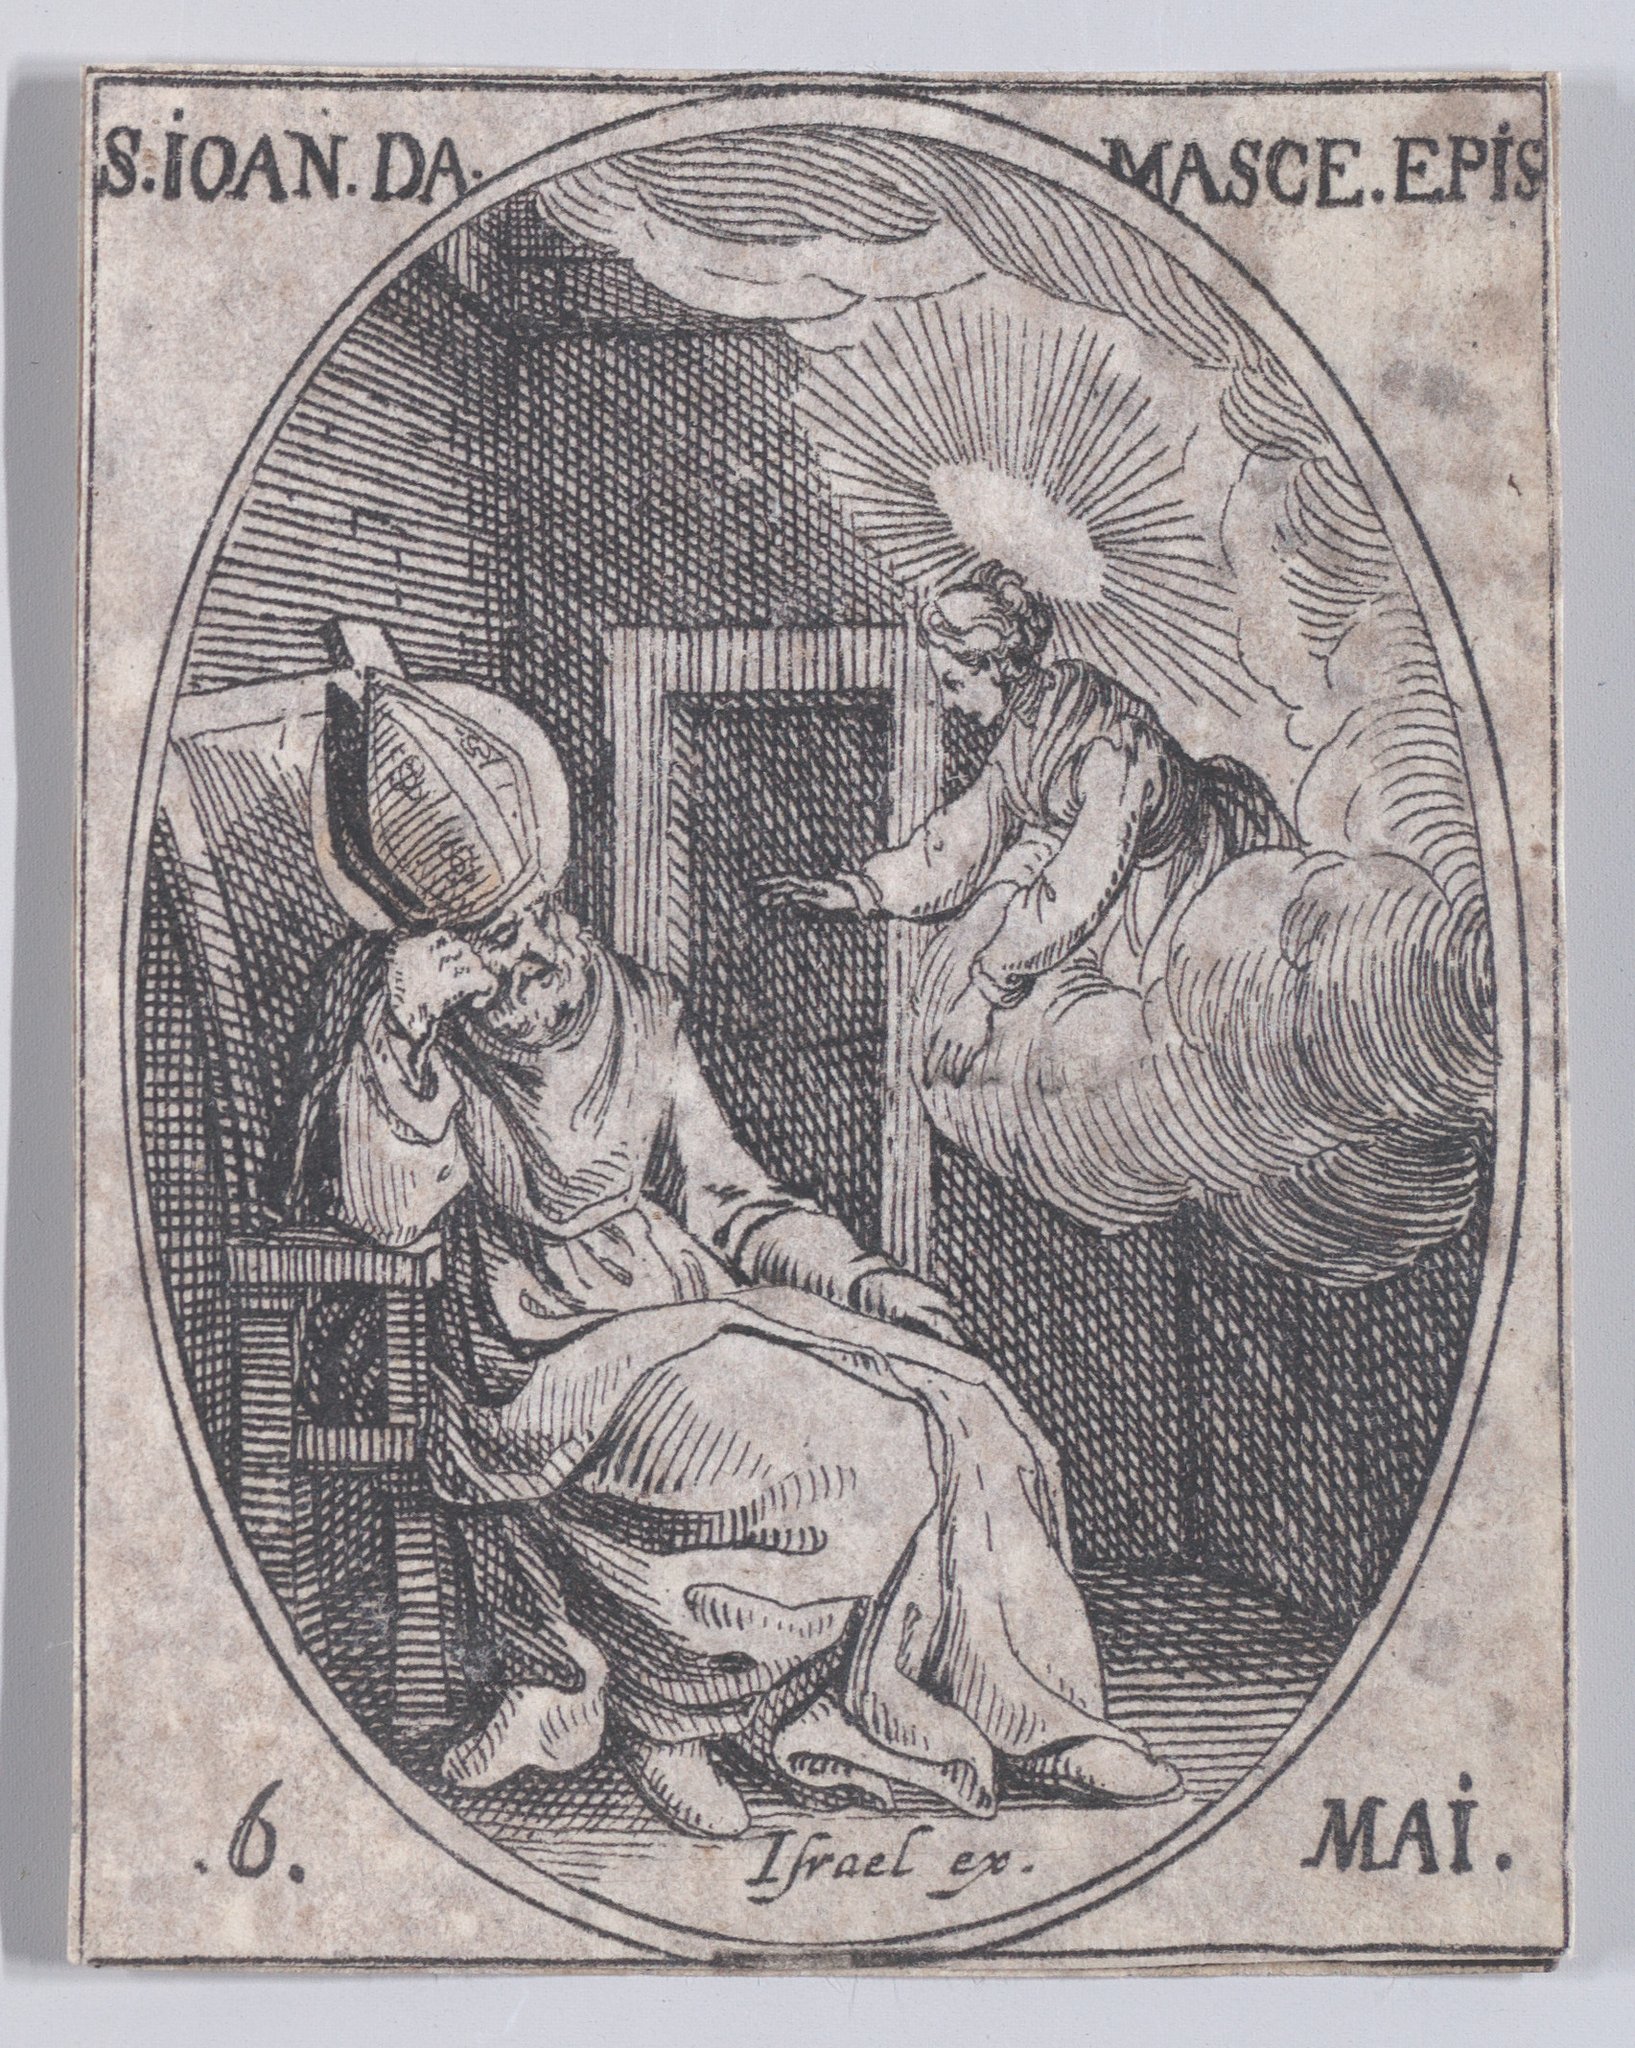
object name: print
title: S. Jean Damascène (St. John of Damascus), May 6th, from "Les Images De Tous Les Saincts et Saintes de L'Année" (Images of All of the Saints and Religious Events of the Year)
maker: jacques callot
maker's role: artist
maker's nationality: french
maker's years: 1592-1635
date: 1636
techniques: etching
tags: men,saints